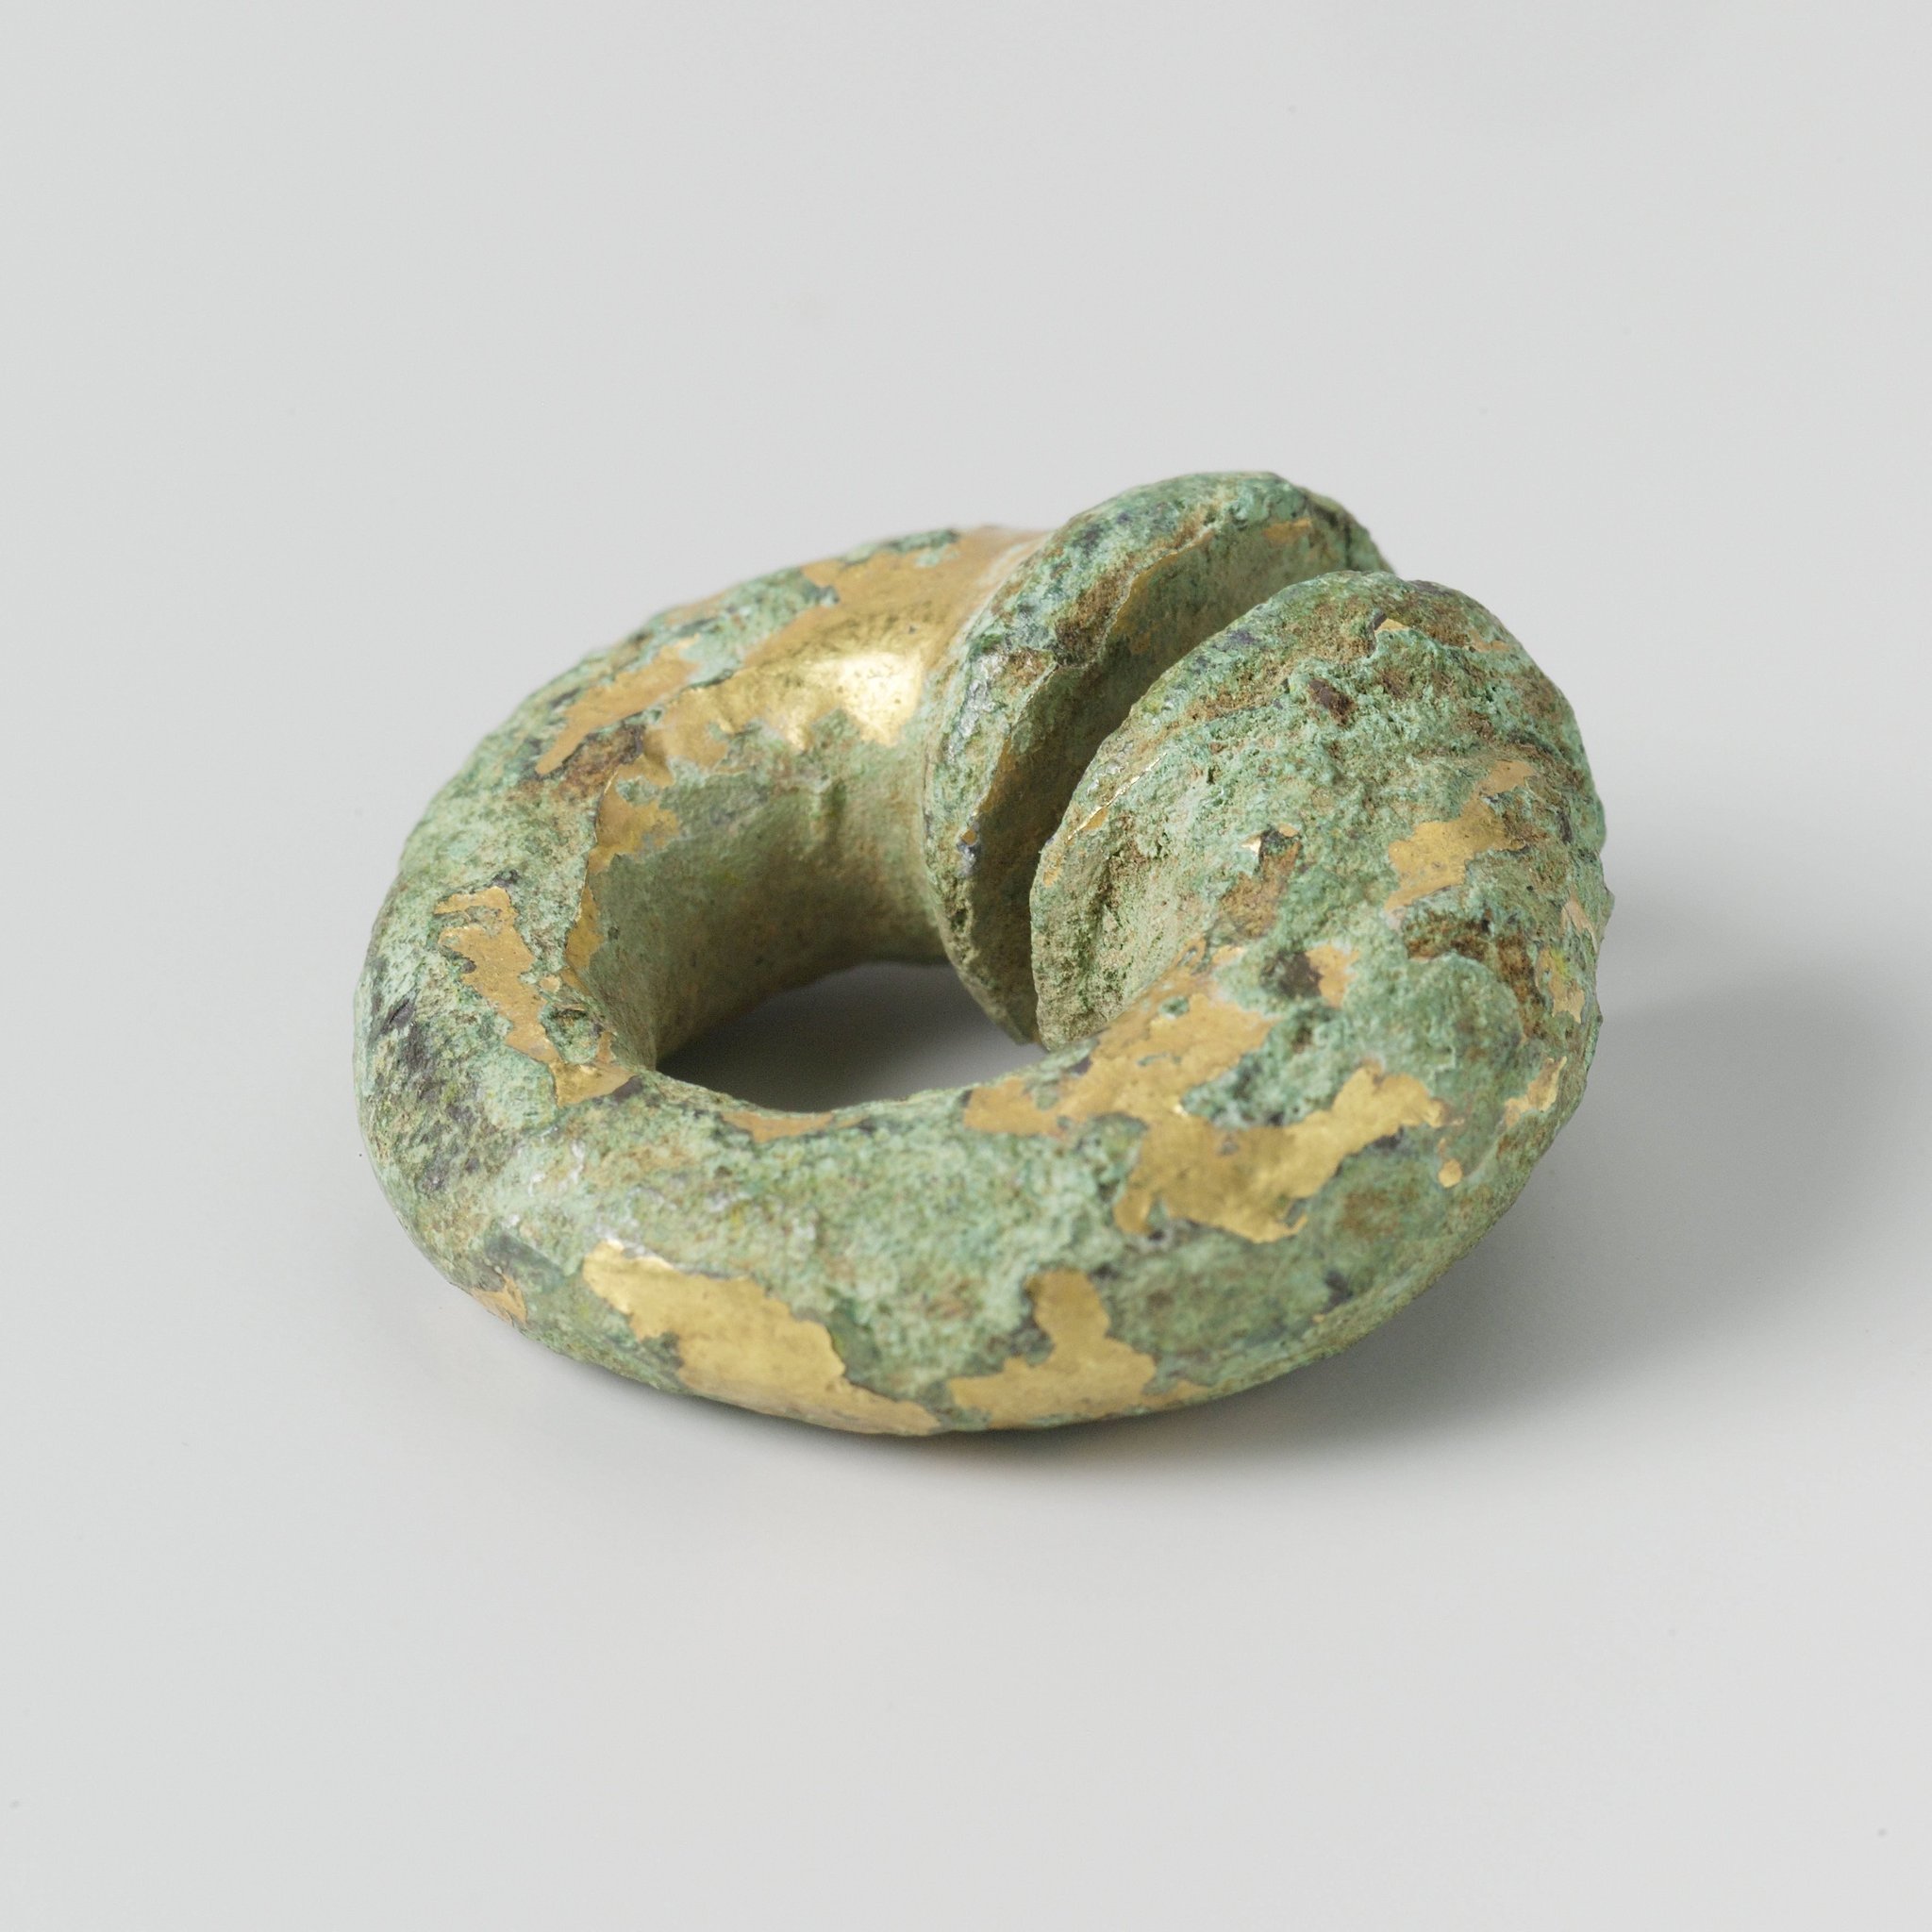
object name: ring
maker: Anonymous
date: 300-600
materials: bronze, gold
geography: java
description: Ring met ronde doorsnede die verbreedt naar de opening toe.